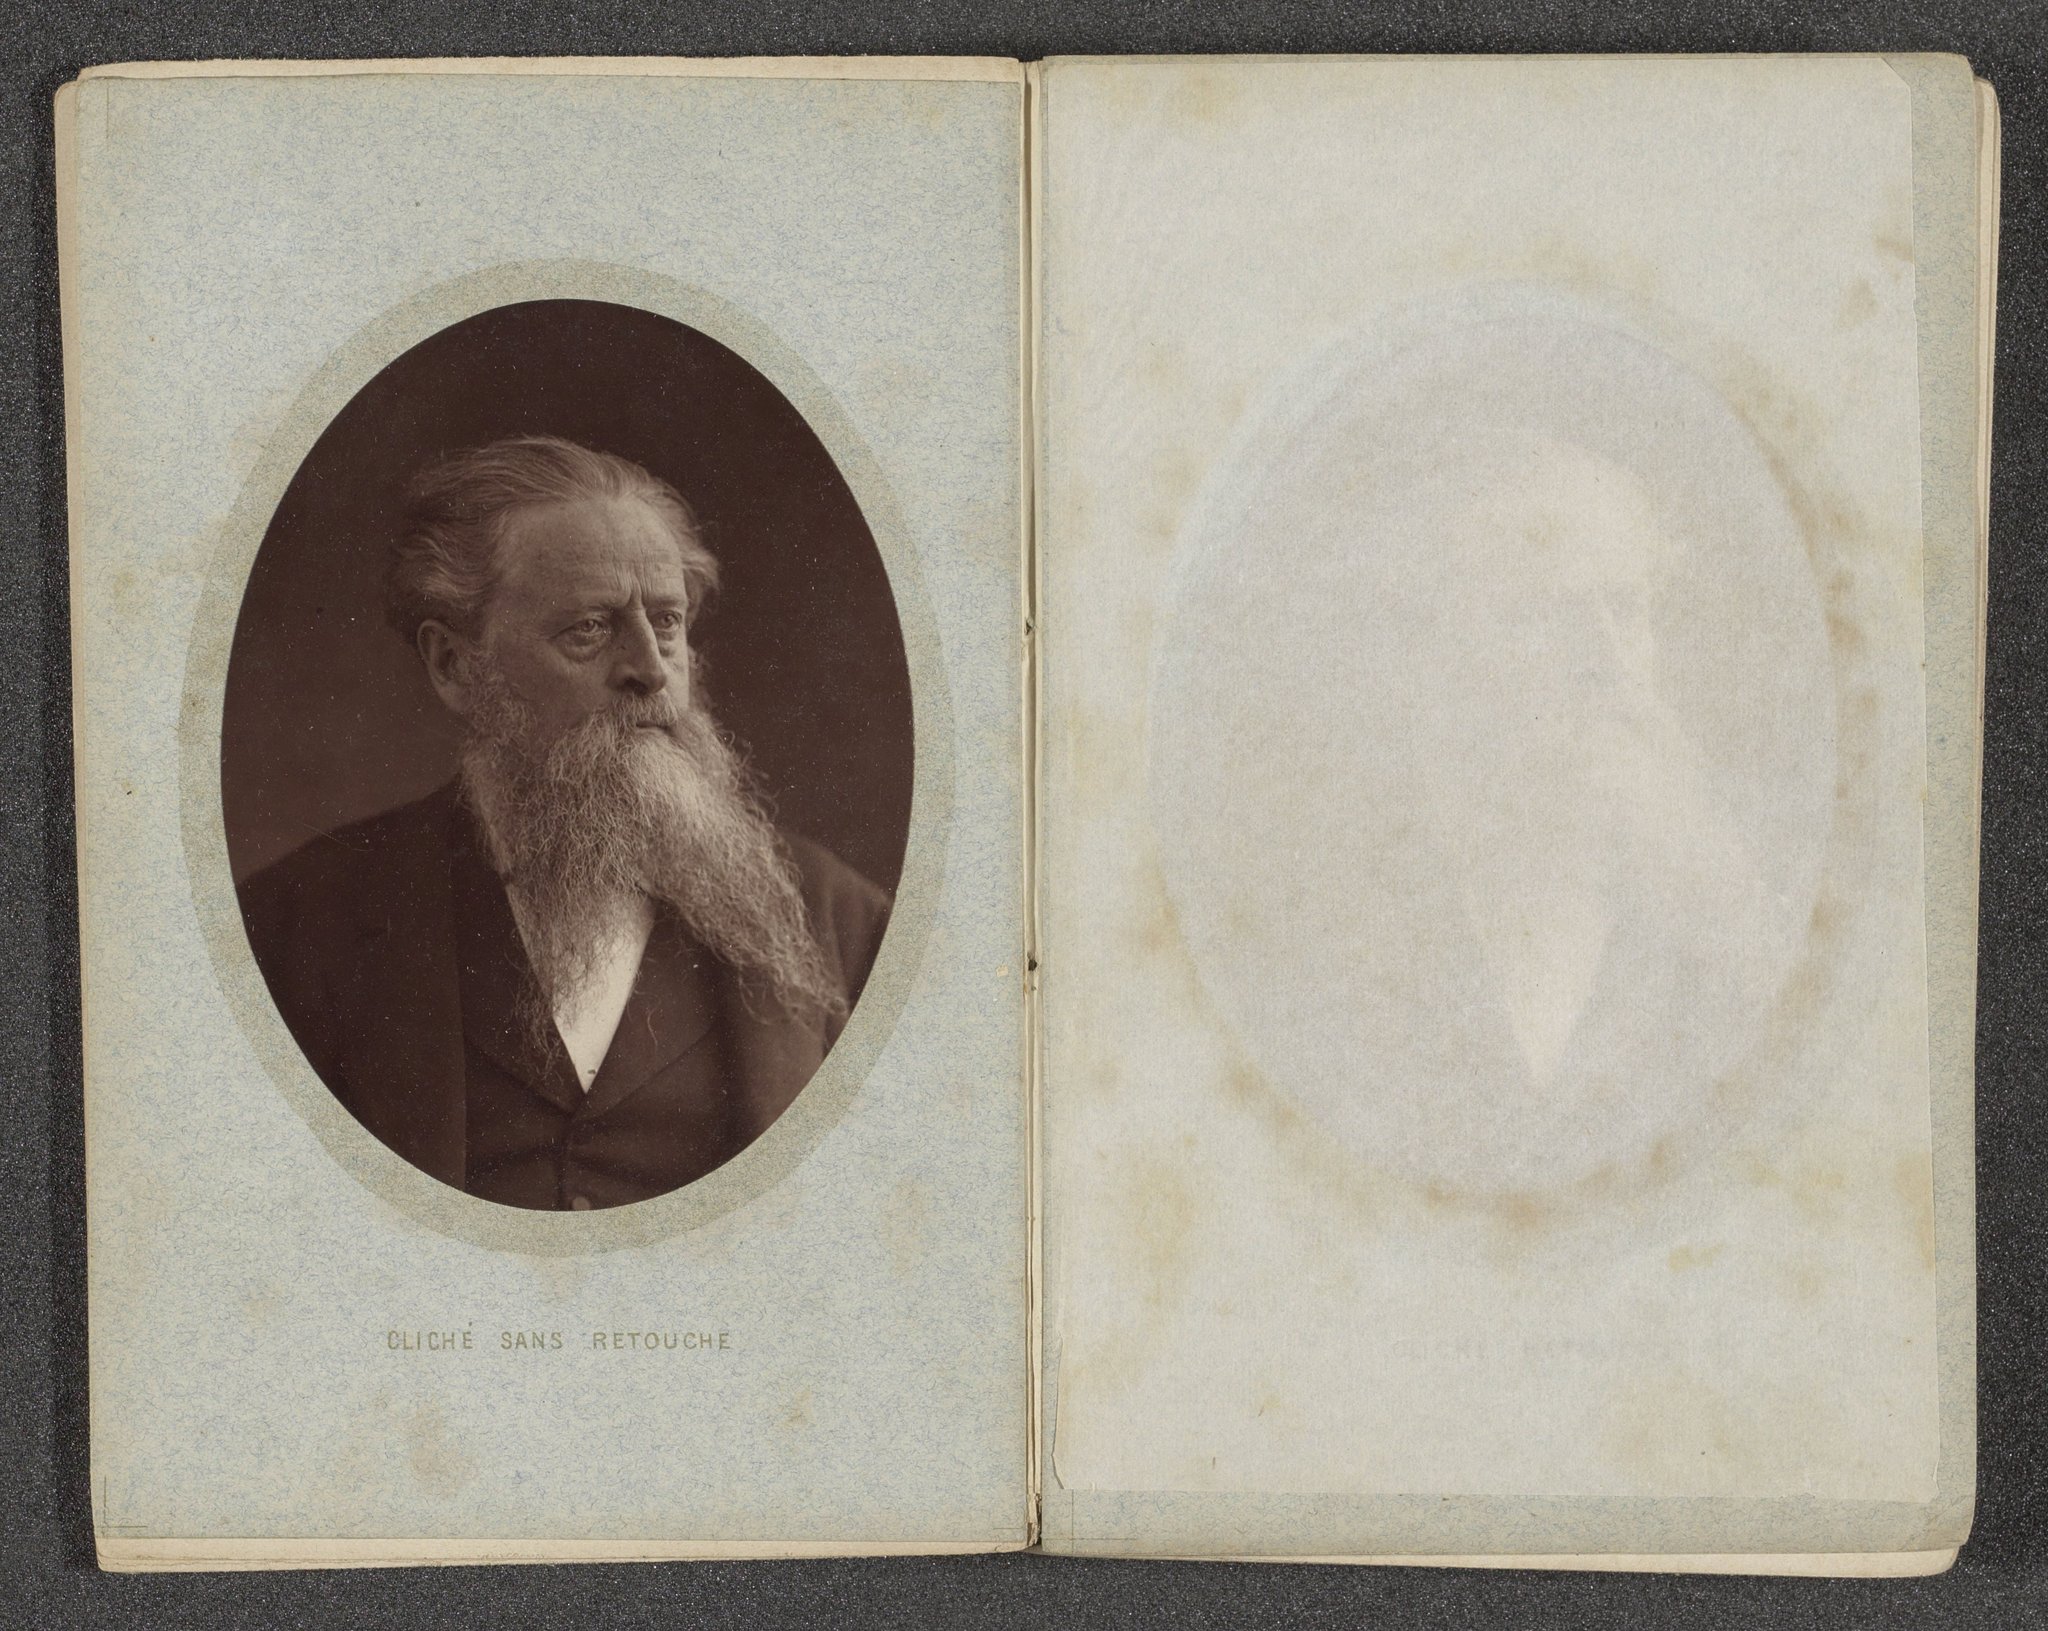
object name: photomechanical print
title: Portret van een onbekende man met een baard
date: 1871-1881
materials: paper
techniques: woodburytype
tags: historical persons not known by name (+ (full) bust portrait), beard